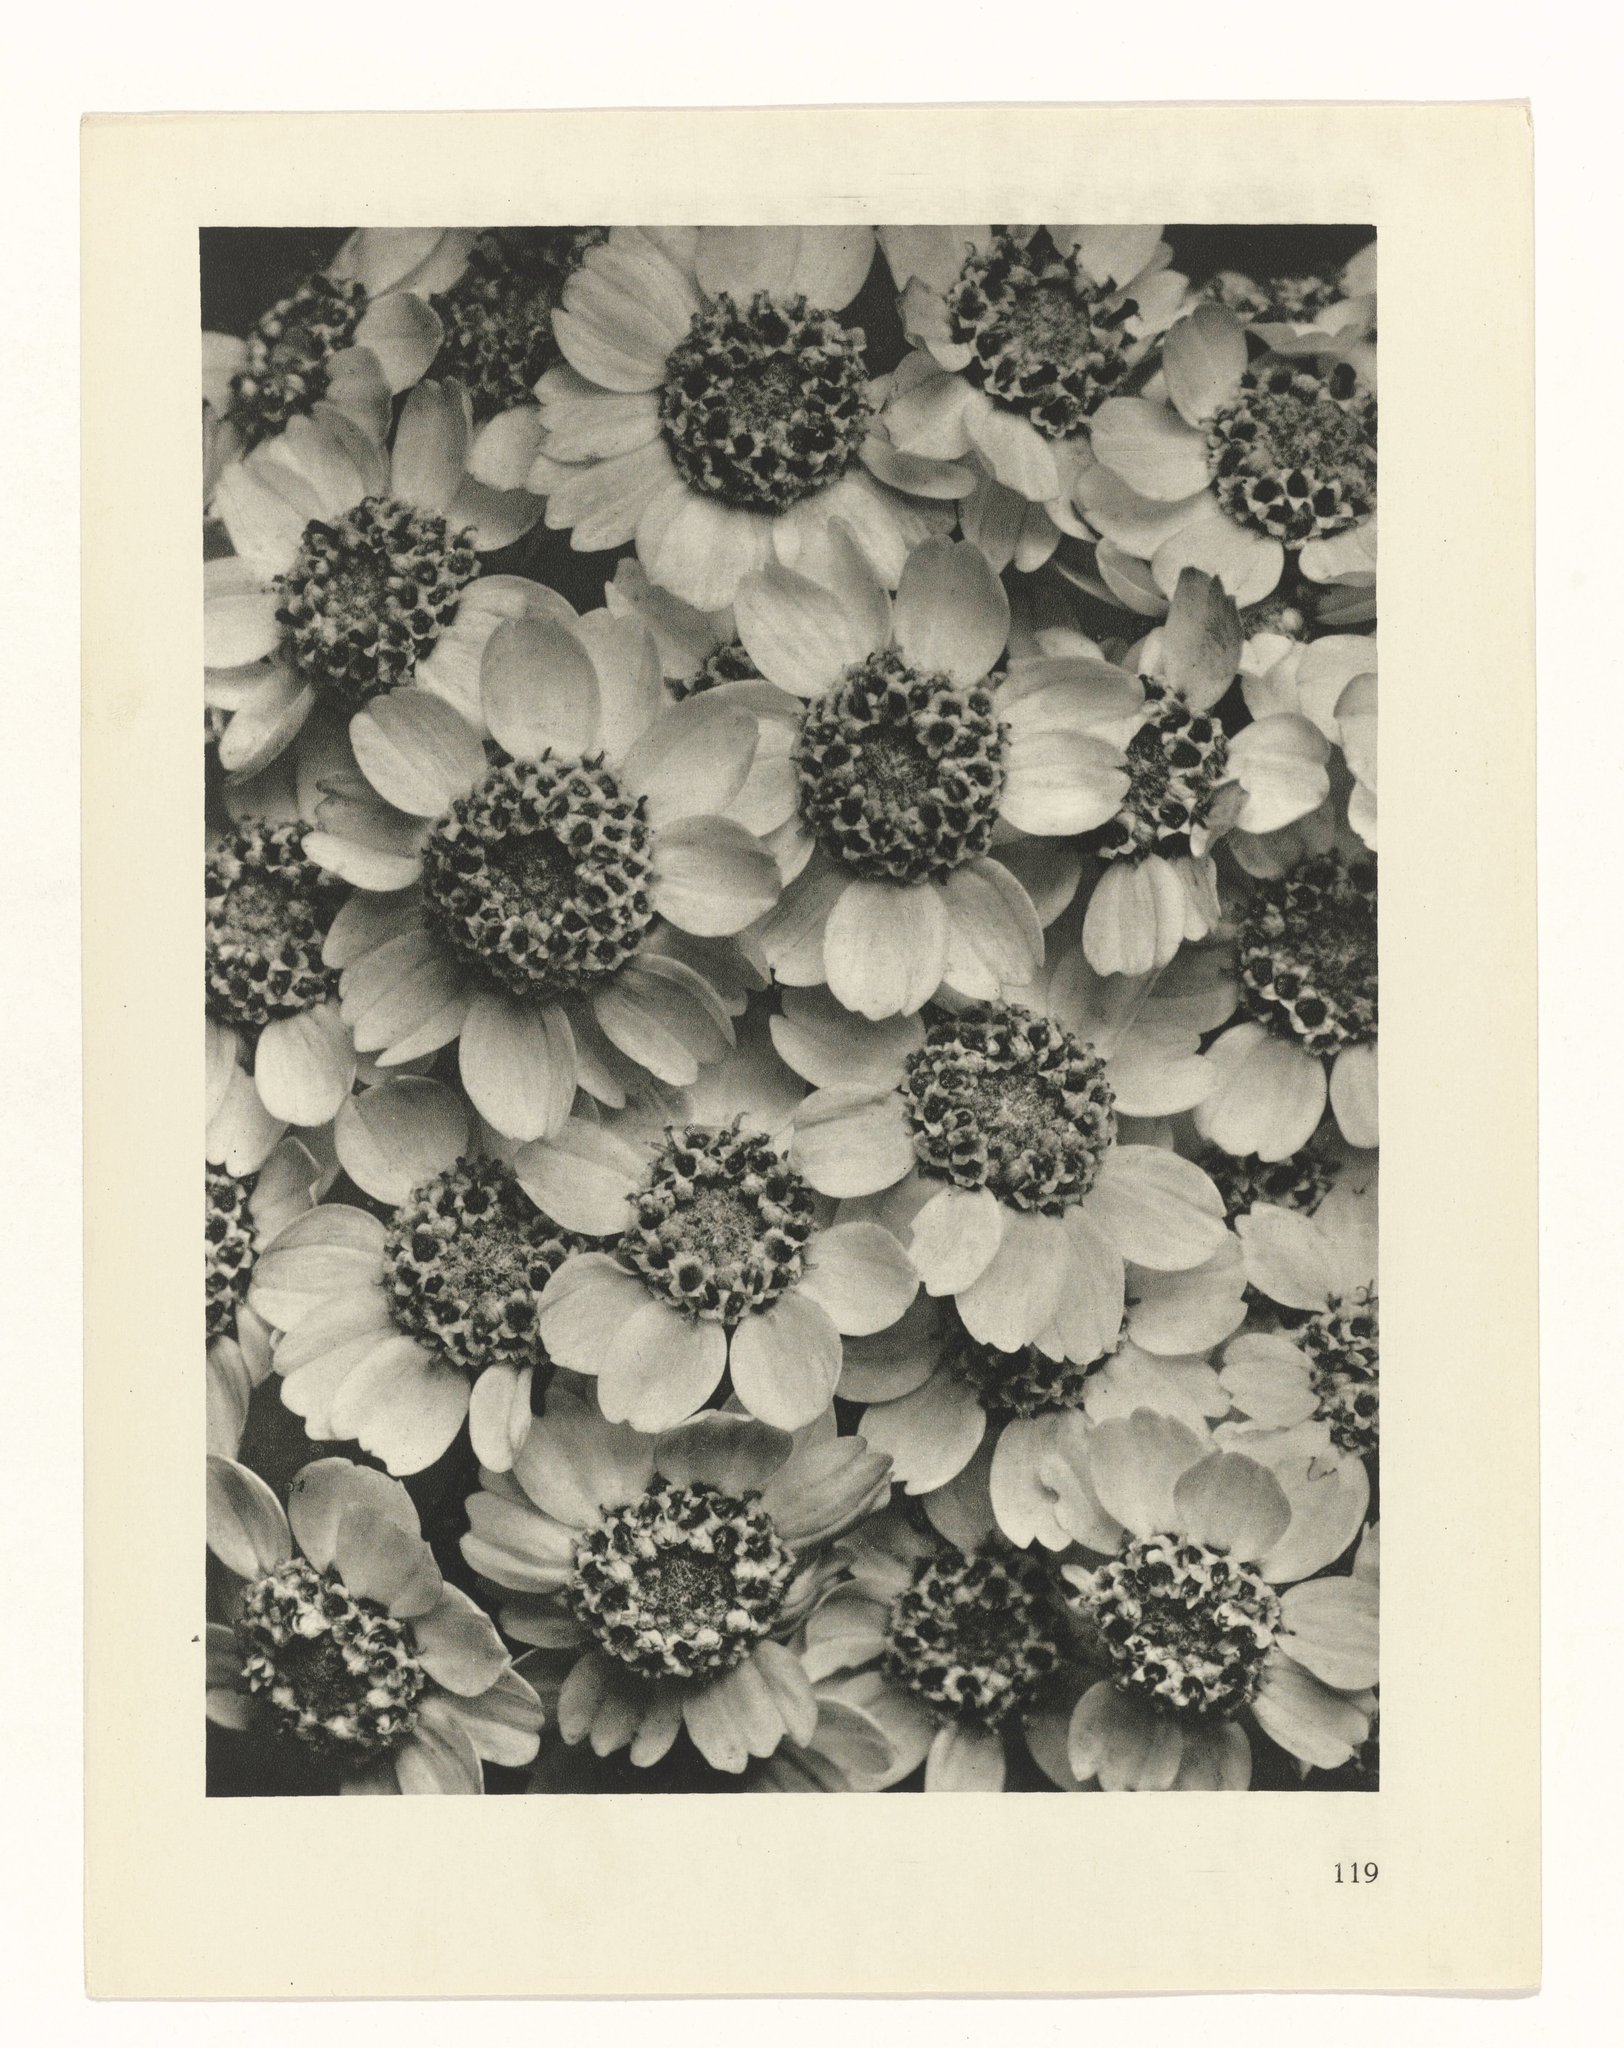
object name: photograph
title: Plantstudie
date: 1928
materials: ink, paper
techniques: rotogravure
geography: berlin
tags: plants (in general)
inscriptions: number: ‘119’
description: facher Vergrößerung. Afkomstig uit losbladige uitgave.